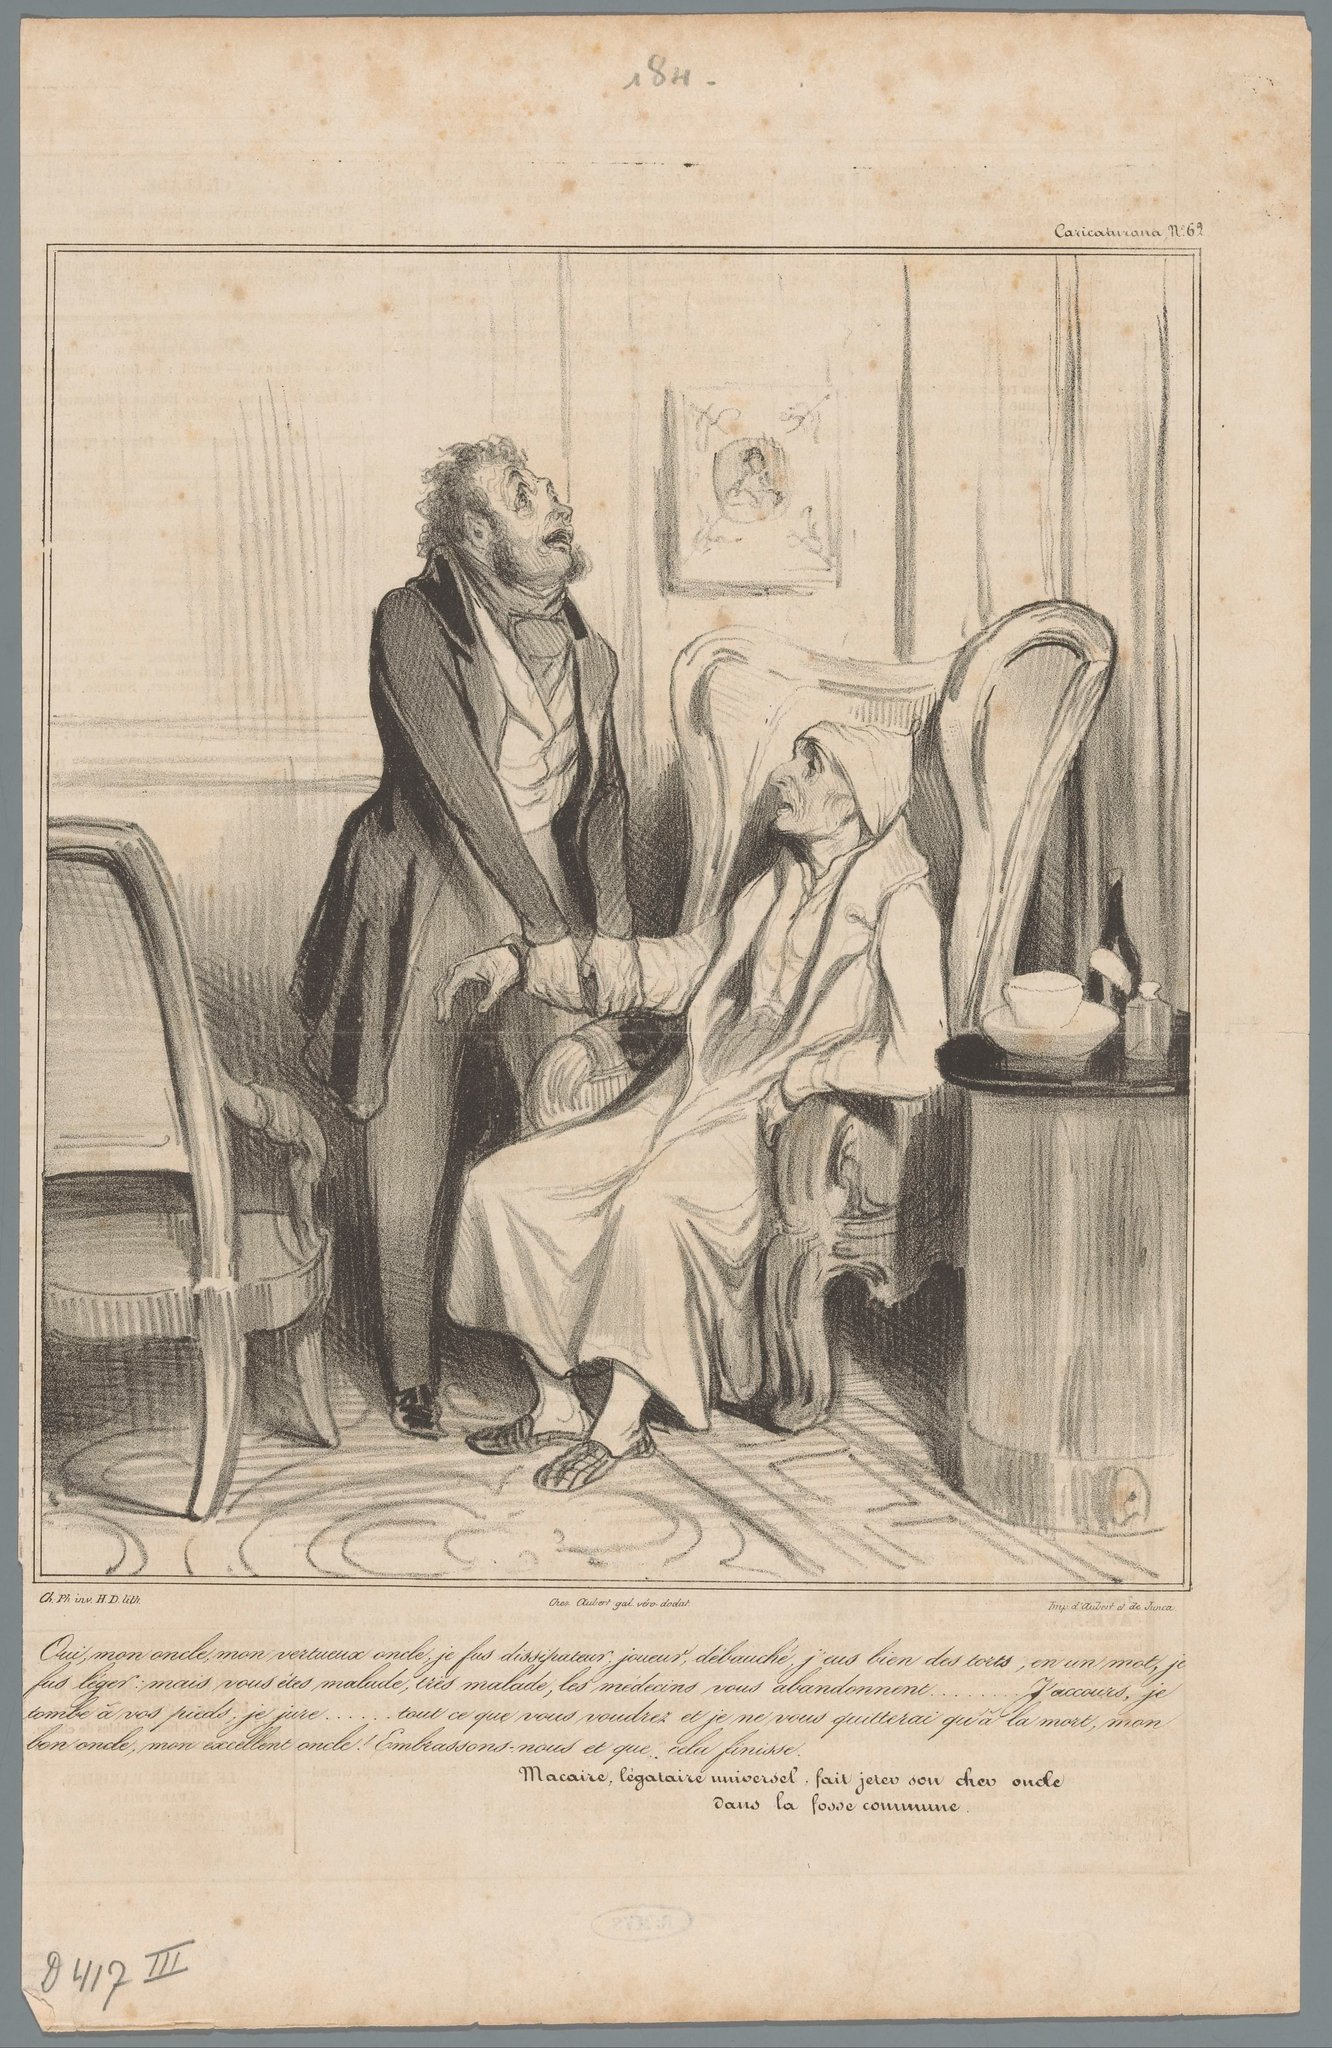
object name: cartoon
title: Robert Macaire bij zijn stervende oom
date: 1837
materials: paper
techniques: letterpress printing, lithograph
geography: paris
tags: caricatures (human types), last words and last favours, nuncupate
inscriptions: collector's mark: Lugt 2228a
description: Robert Macaire beweert tegen zijn oom dat hij zijn leven gebeterd heeft.